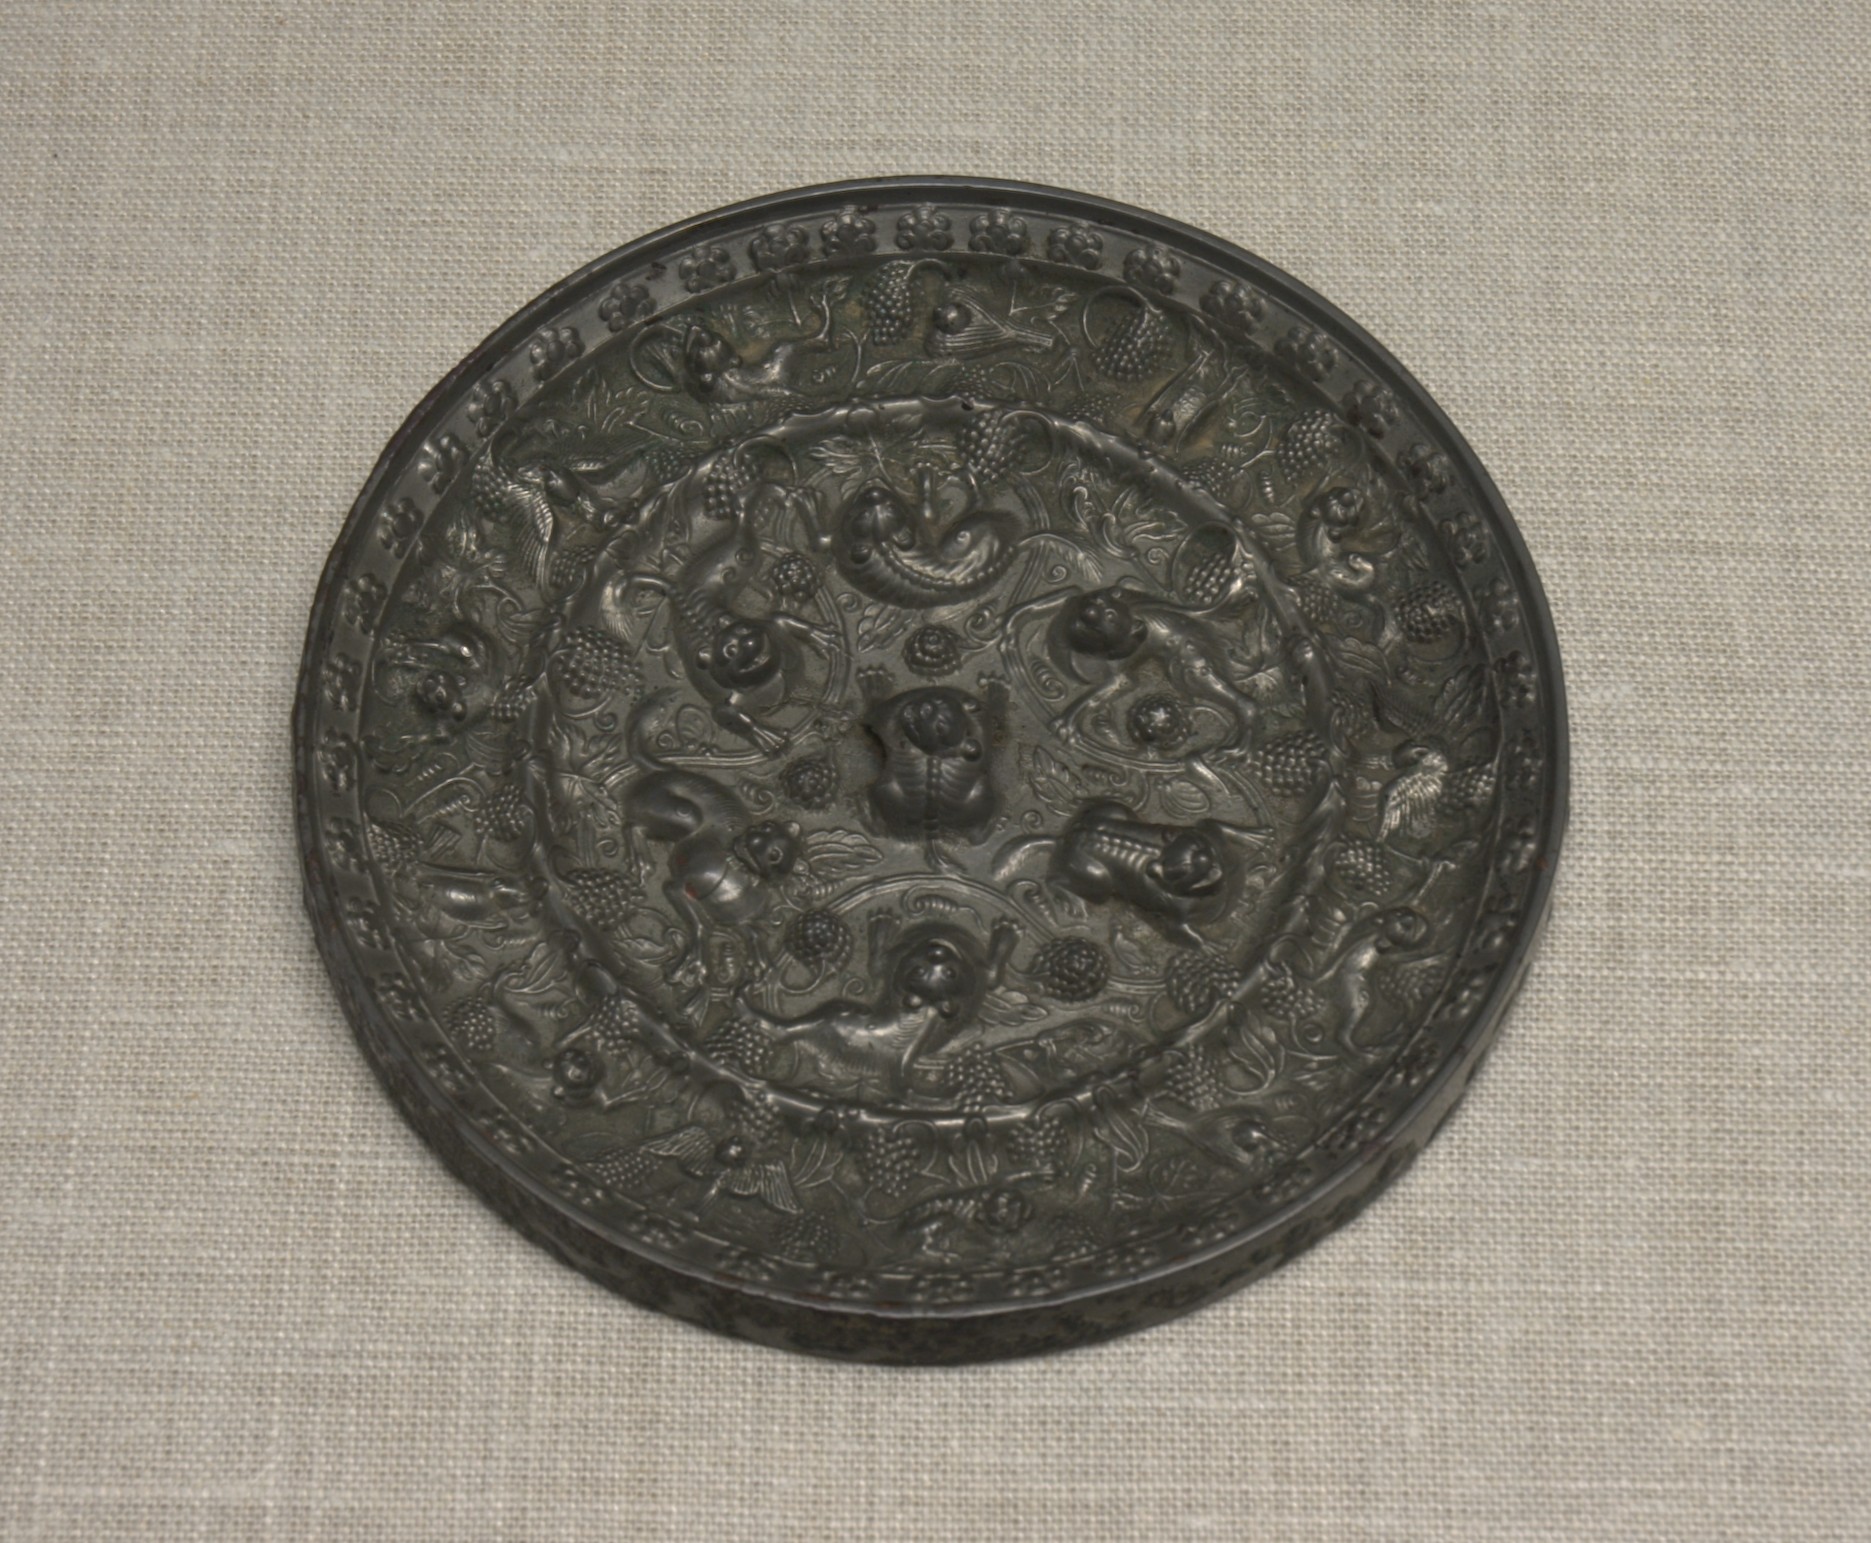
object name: mirror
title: Mirror with fantastic animals amid grape vines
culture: chinese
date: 601-800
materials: bronze